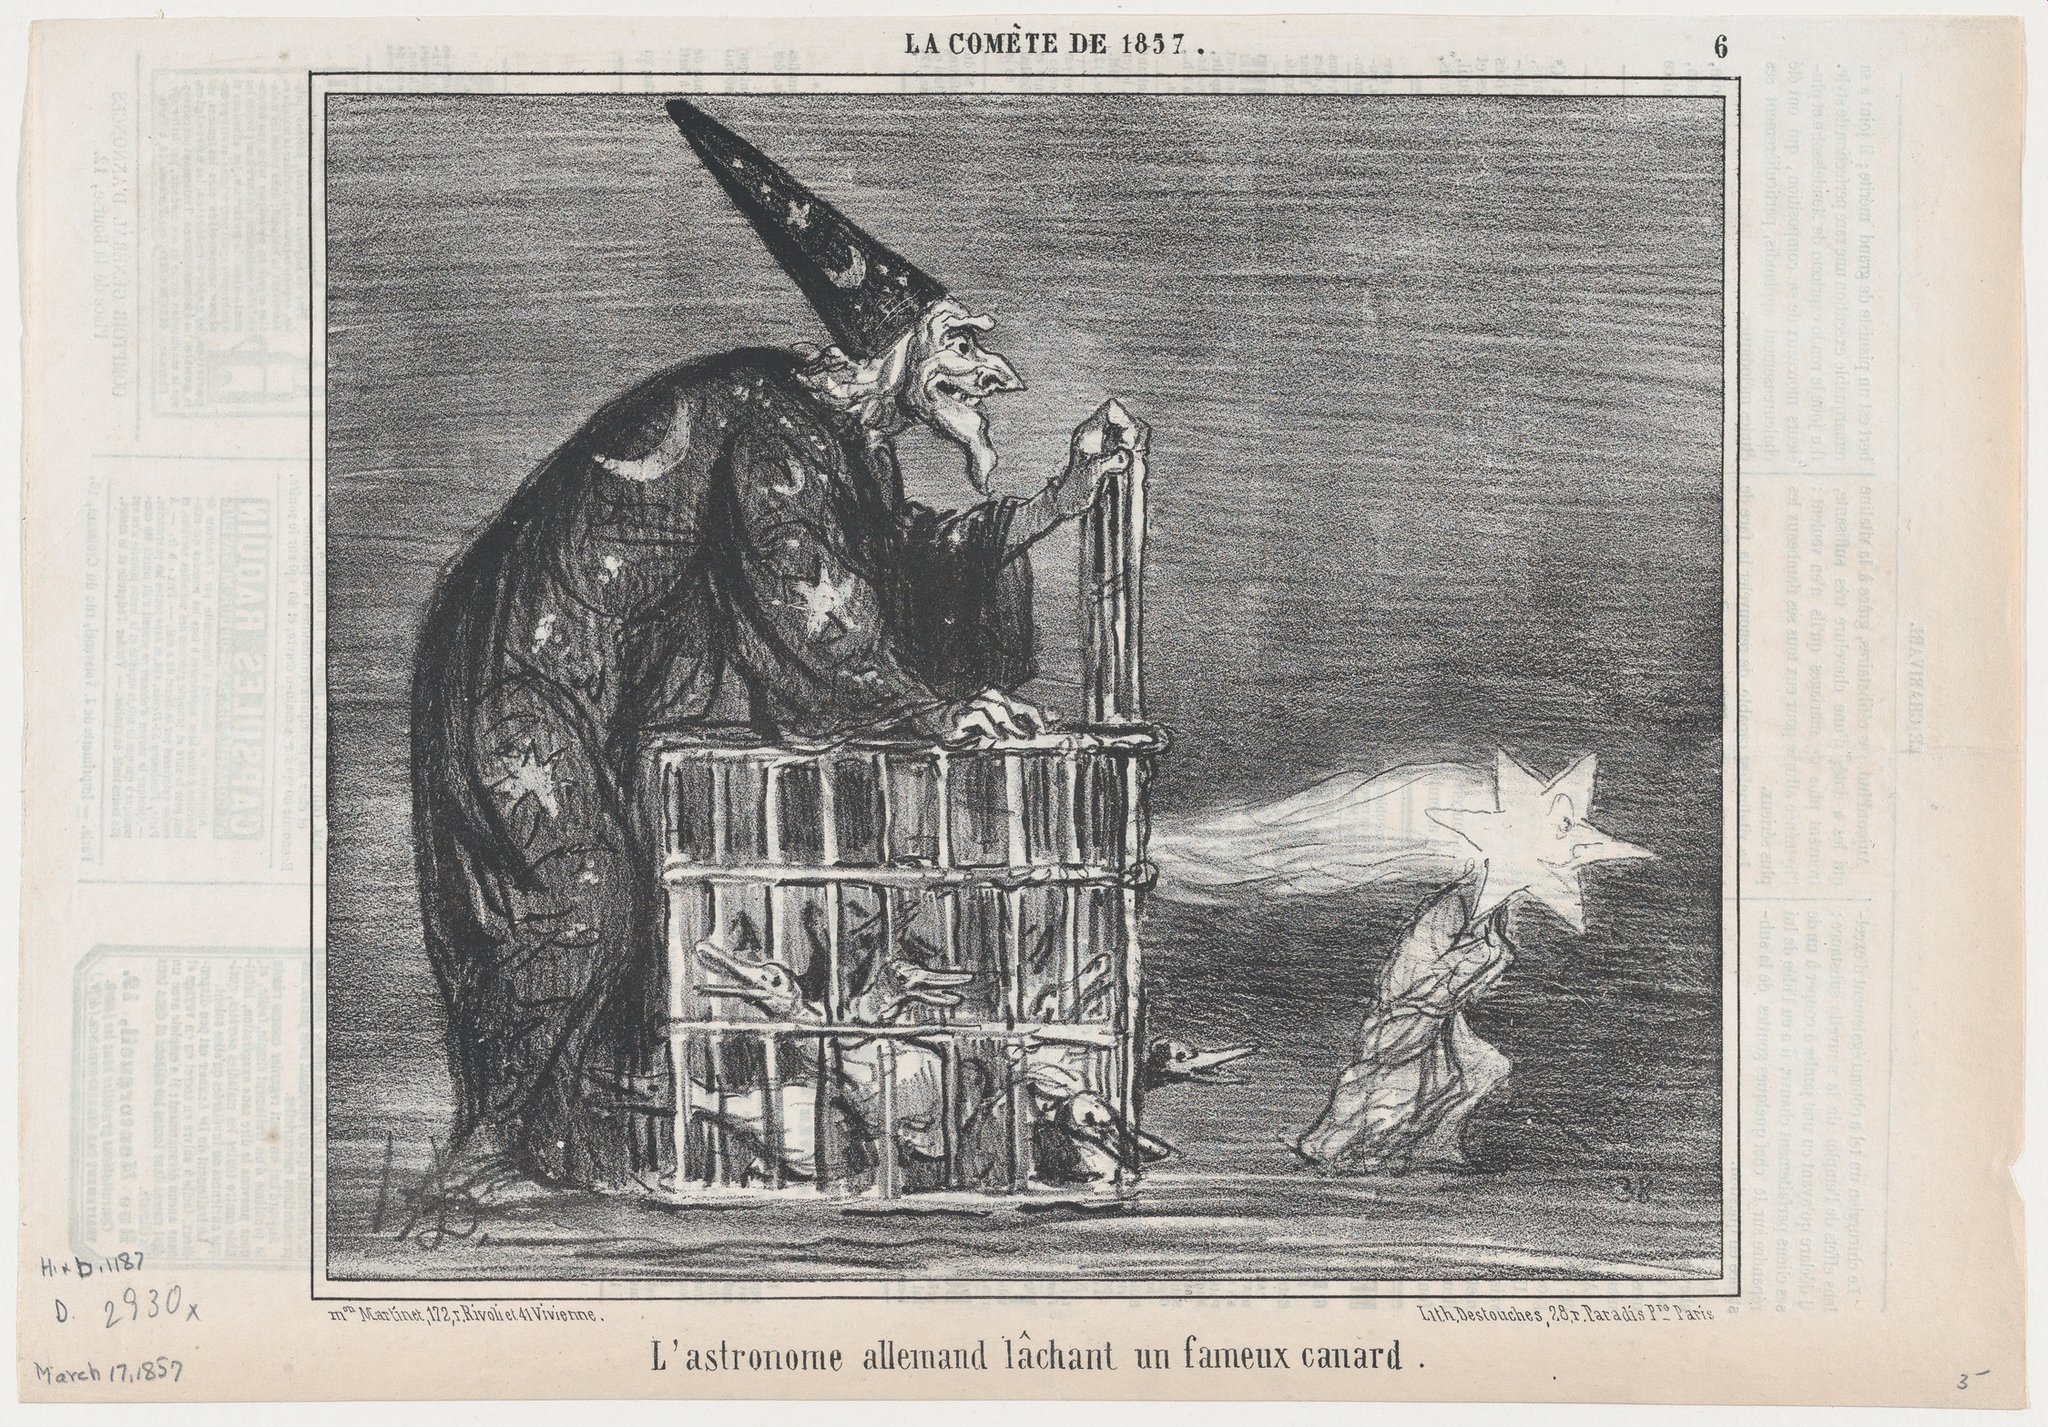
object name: print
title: L'astronome allemand lâchant un fameux canard, from La Comète de 1857, published in Le Charivari, March 17, 1857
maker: honoré daumier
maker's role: artist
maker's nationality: french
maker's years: 1808-1879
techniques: lithograph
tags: ducks,satire,astronomers